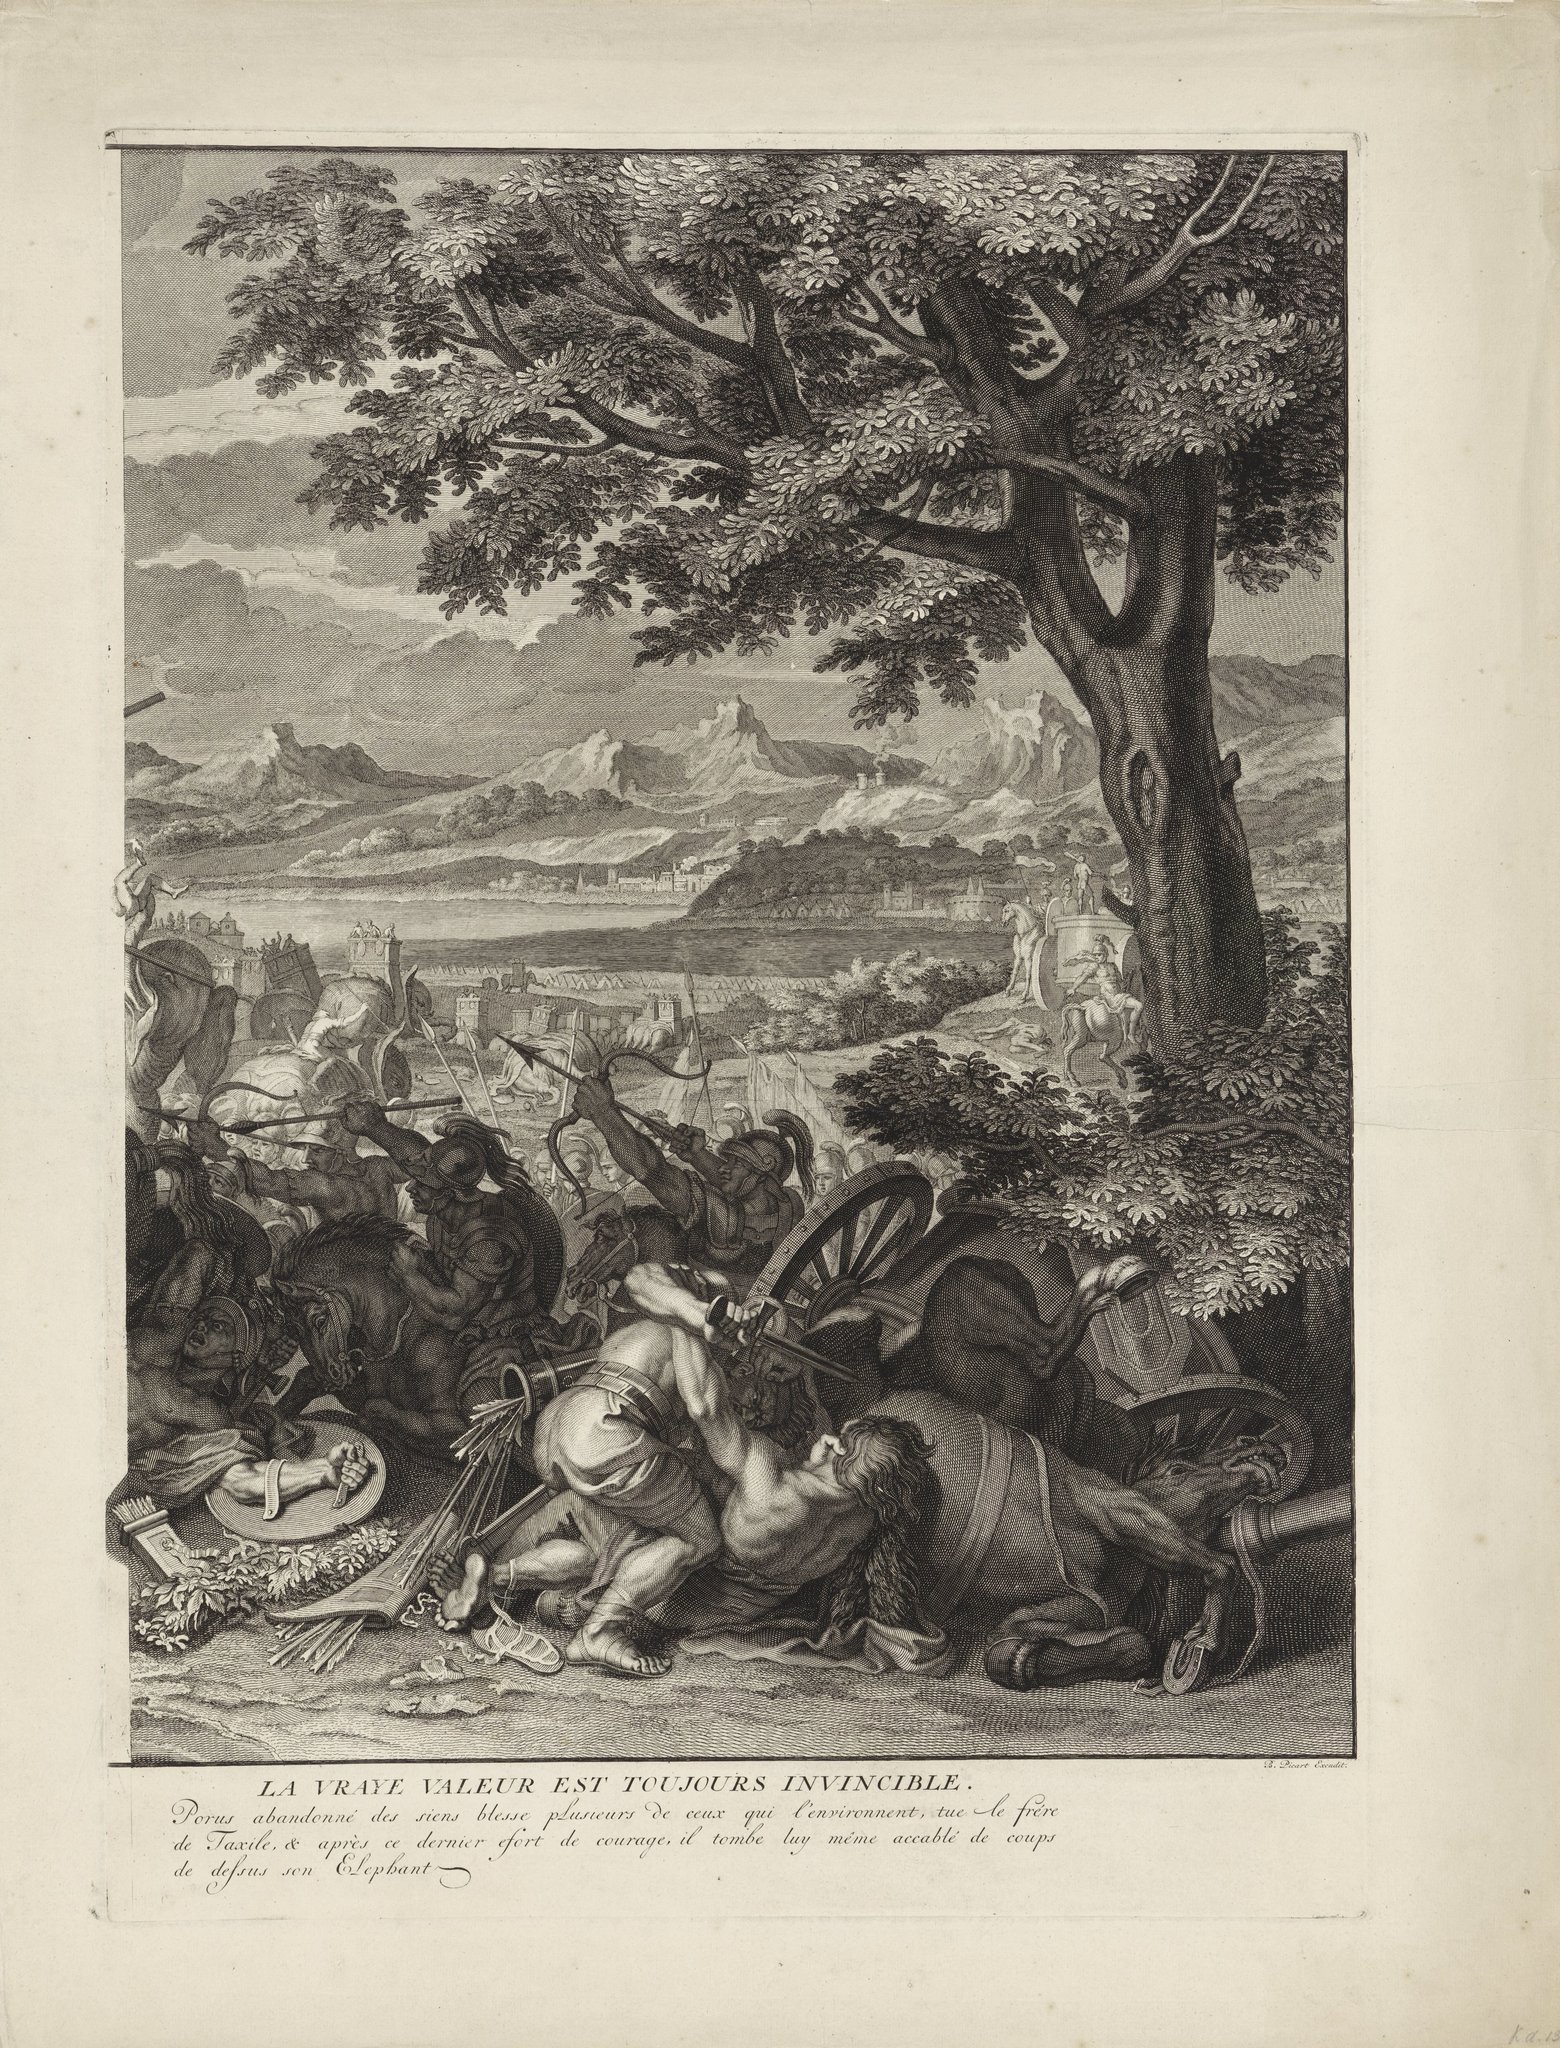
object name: print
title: Veldslag van Alexander de Grote en Poros (plaat 3)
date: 1717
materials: paper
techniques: engraving, etching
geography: paris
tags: the army of porus and its elephants are conquered by alexander, battle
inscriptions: collector's mark: Lugt 240, inscription: ‘Kd. 13’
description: Rechter blad van een prent gedrukt van drie platen.